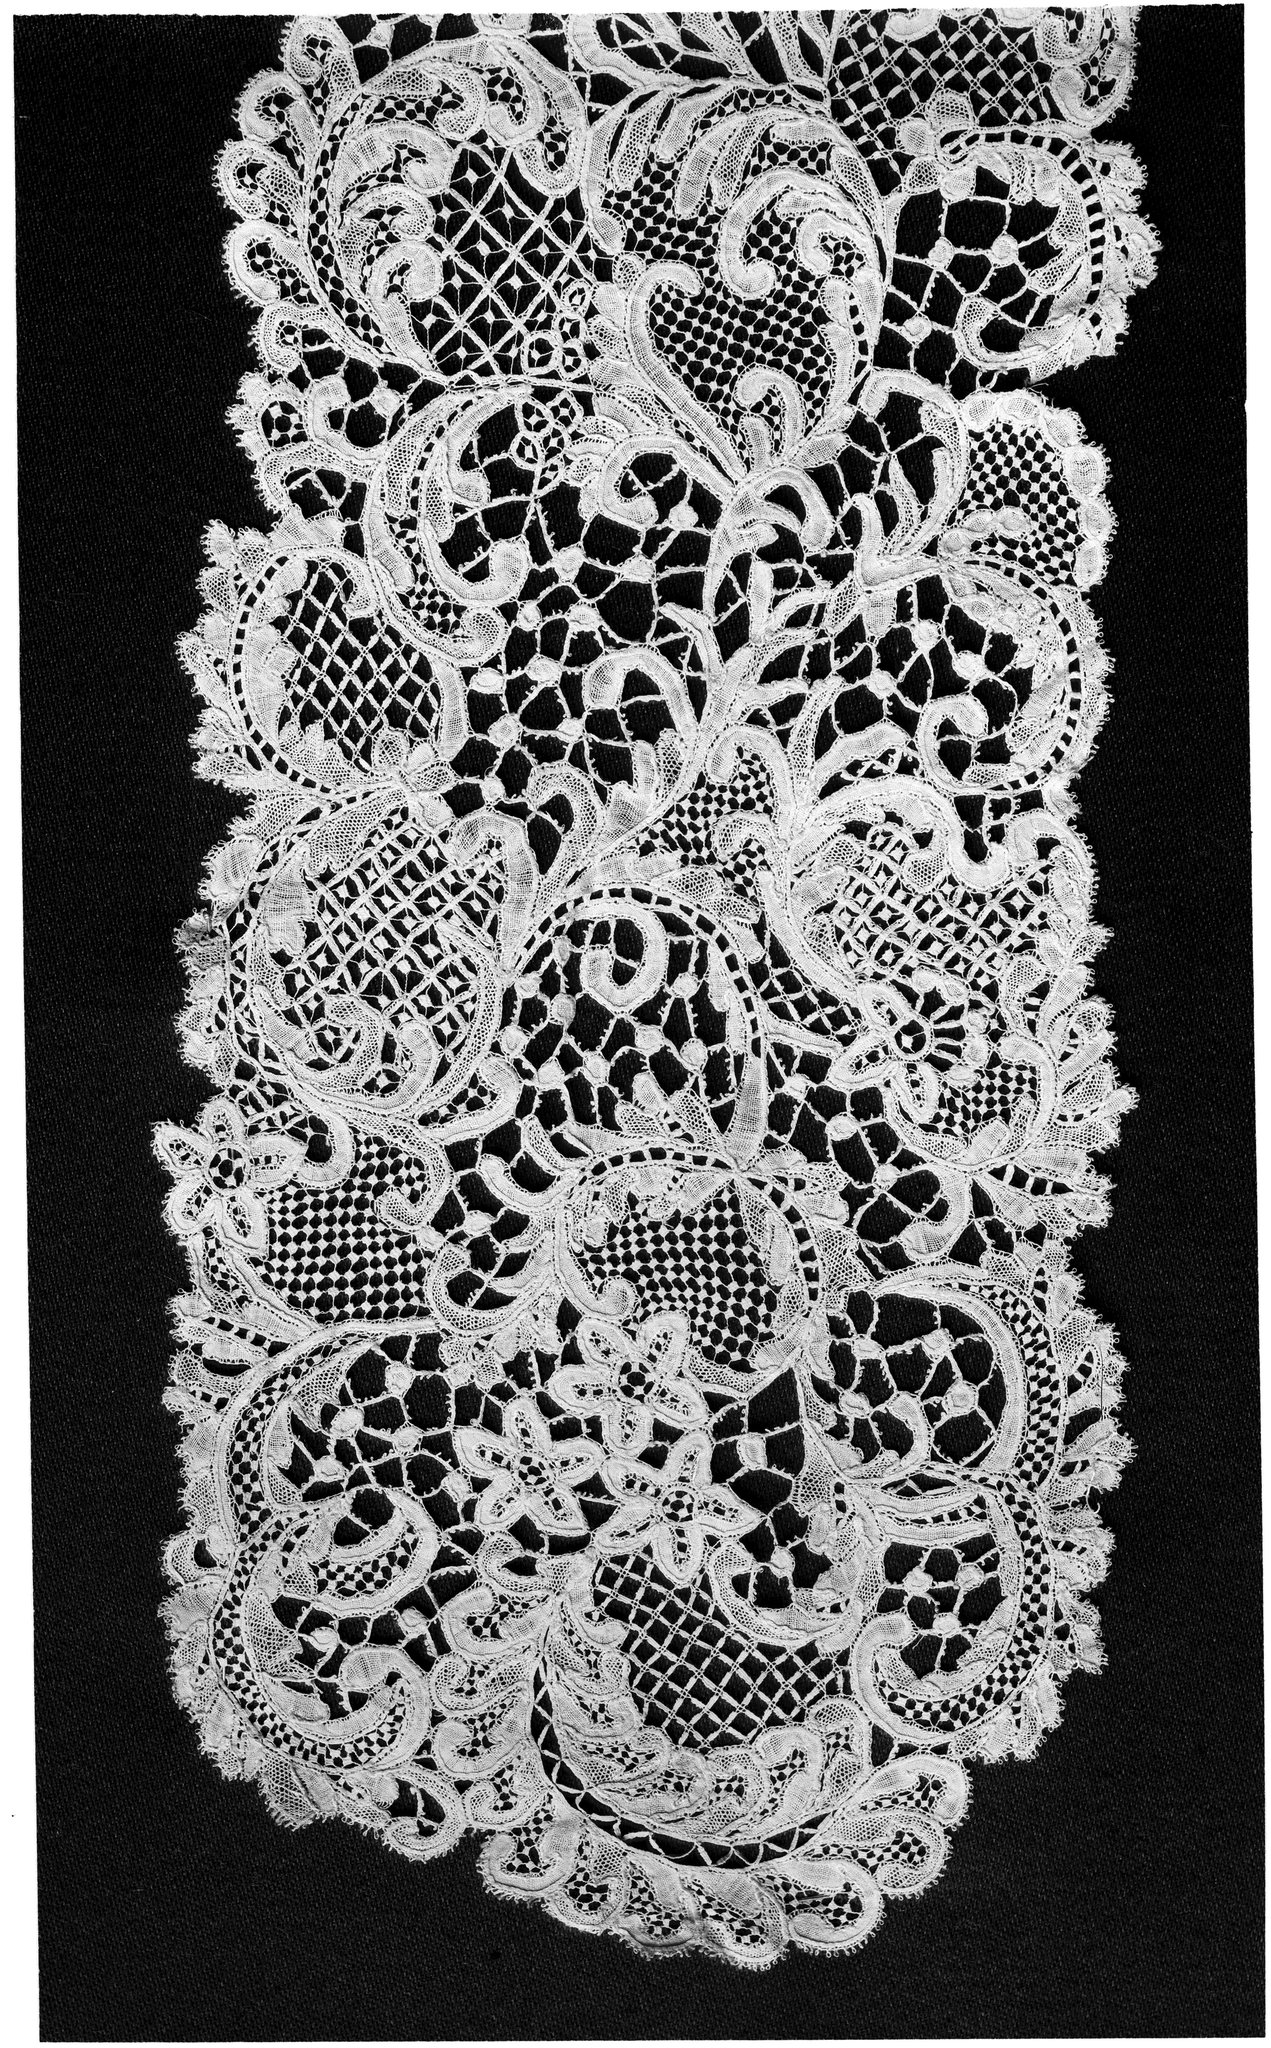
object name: barbe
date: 1767-1800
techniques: lace